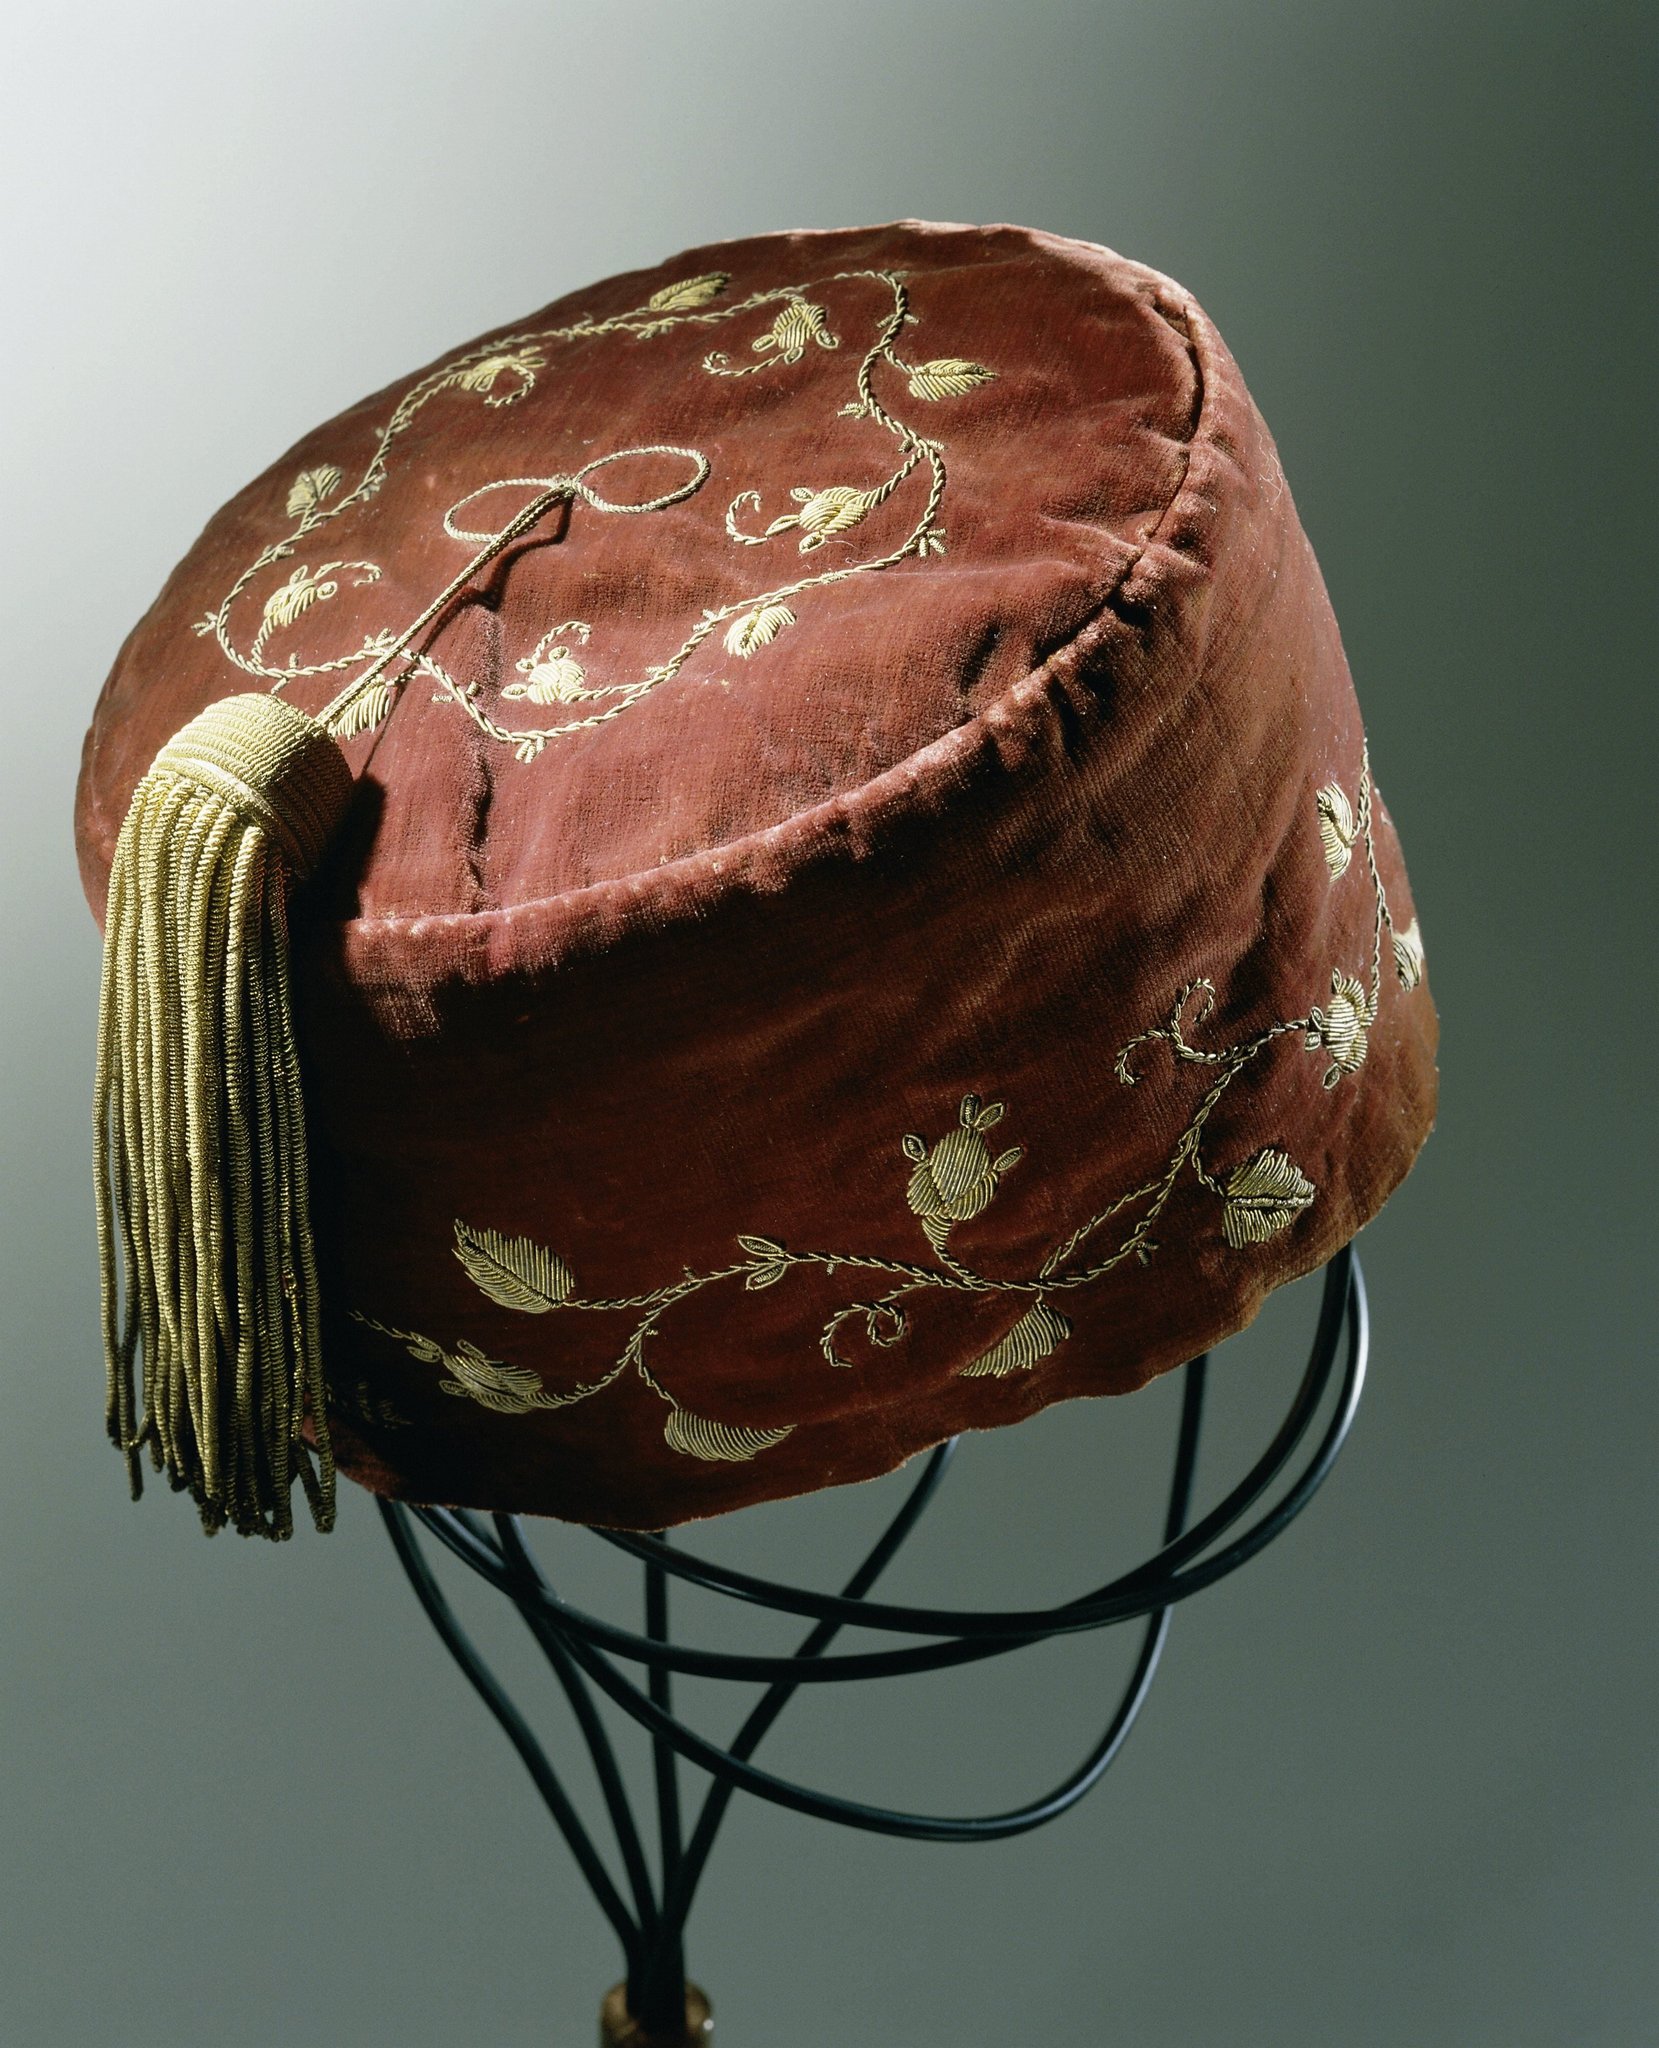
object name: clothing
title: Kalot of 'smoking cap' van bordeauxrood fluweel, geborduurd met gouddraad en voorzien van een kwast van gouddraad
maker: Anonymous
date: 1860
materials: gold thread, silk, velvet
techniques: embroidered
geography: netherlands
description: Smoking cap van bordeauxrood fluweel, geborduurd met gouddraad en voorzien van een kwast van gouddraad.